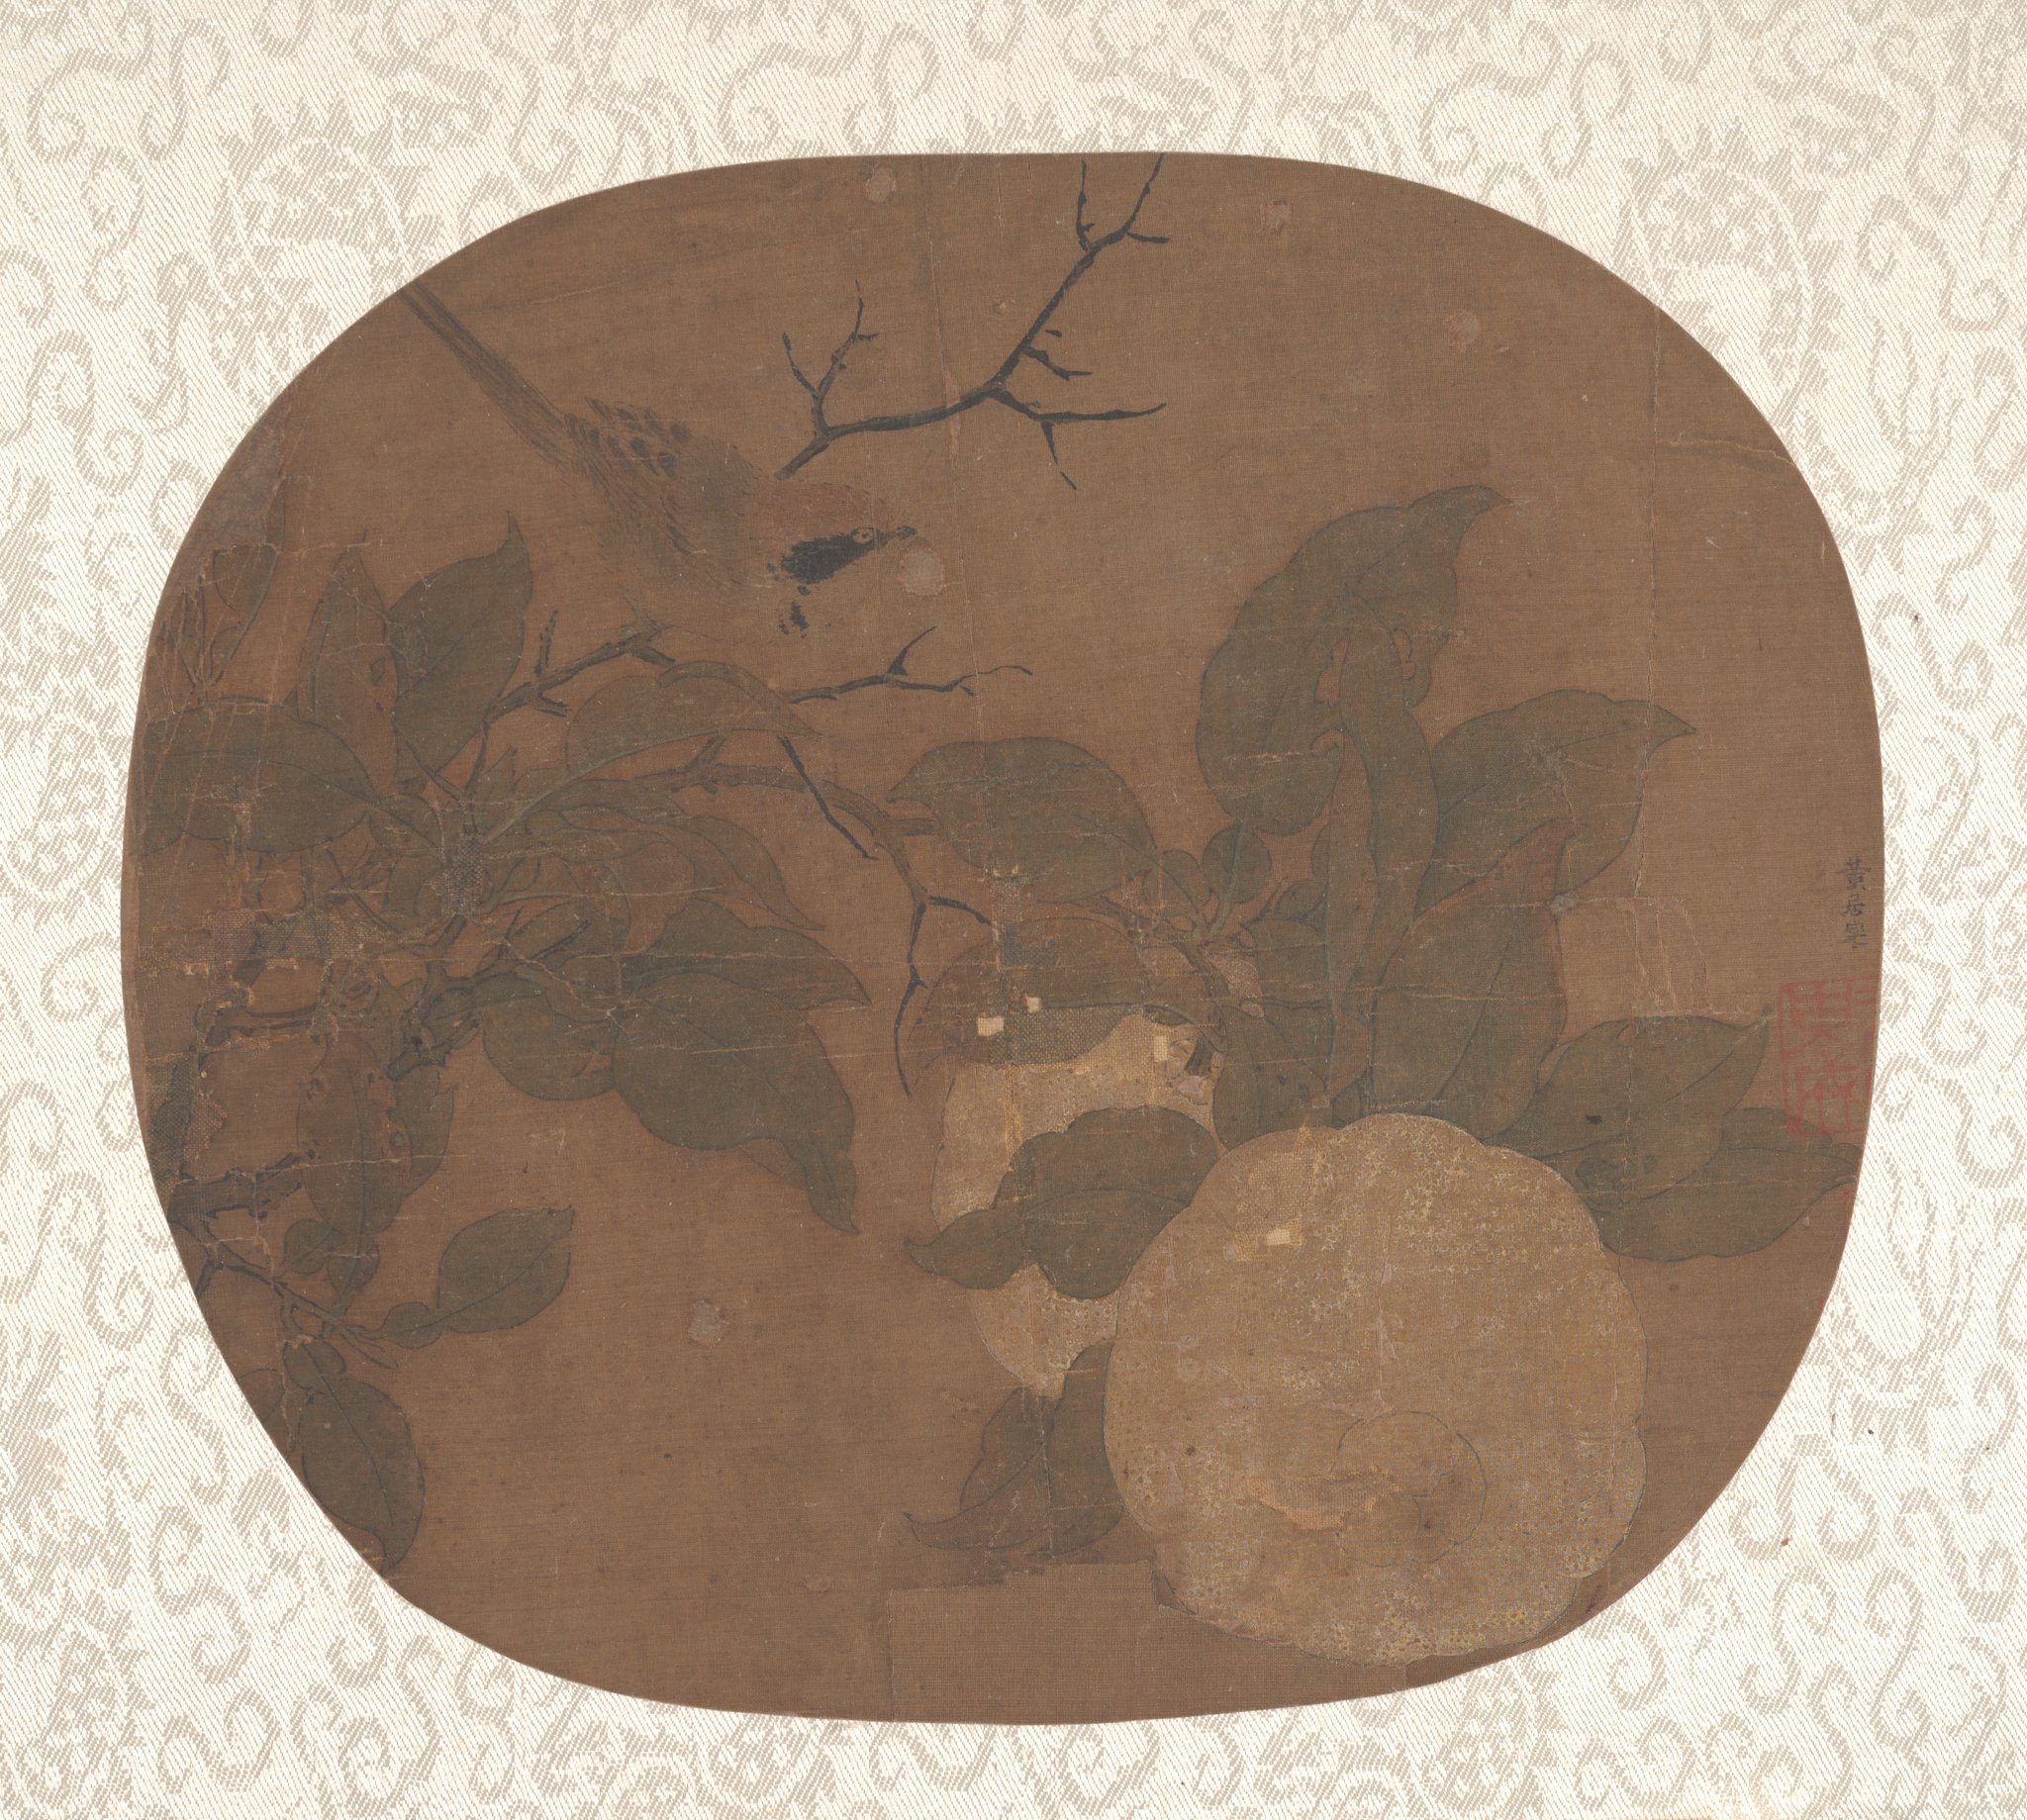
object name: fan mounted a an album leaf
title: Bird on a Camellia Branch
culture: chinese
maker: unidentified artist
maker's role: artist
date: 1000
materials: ink, silk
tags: birds,flowers